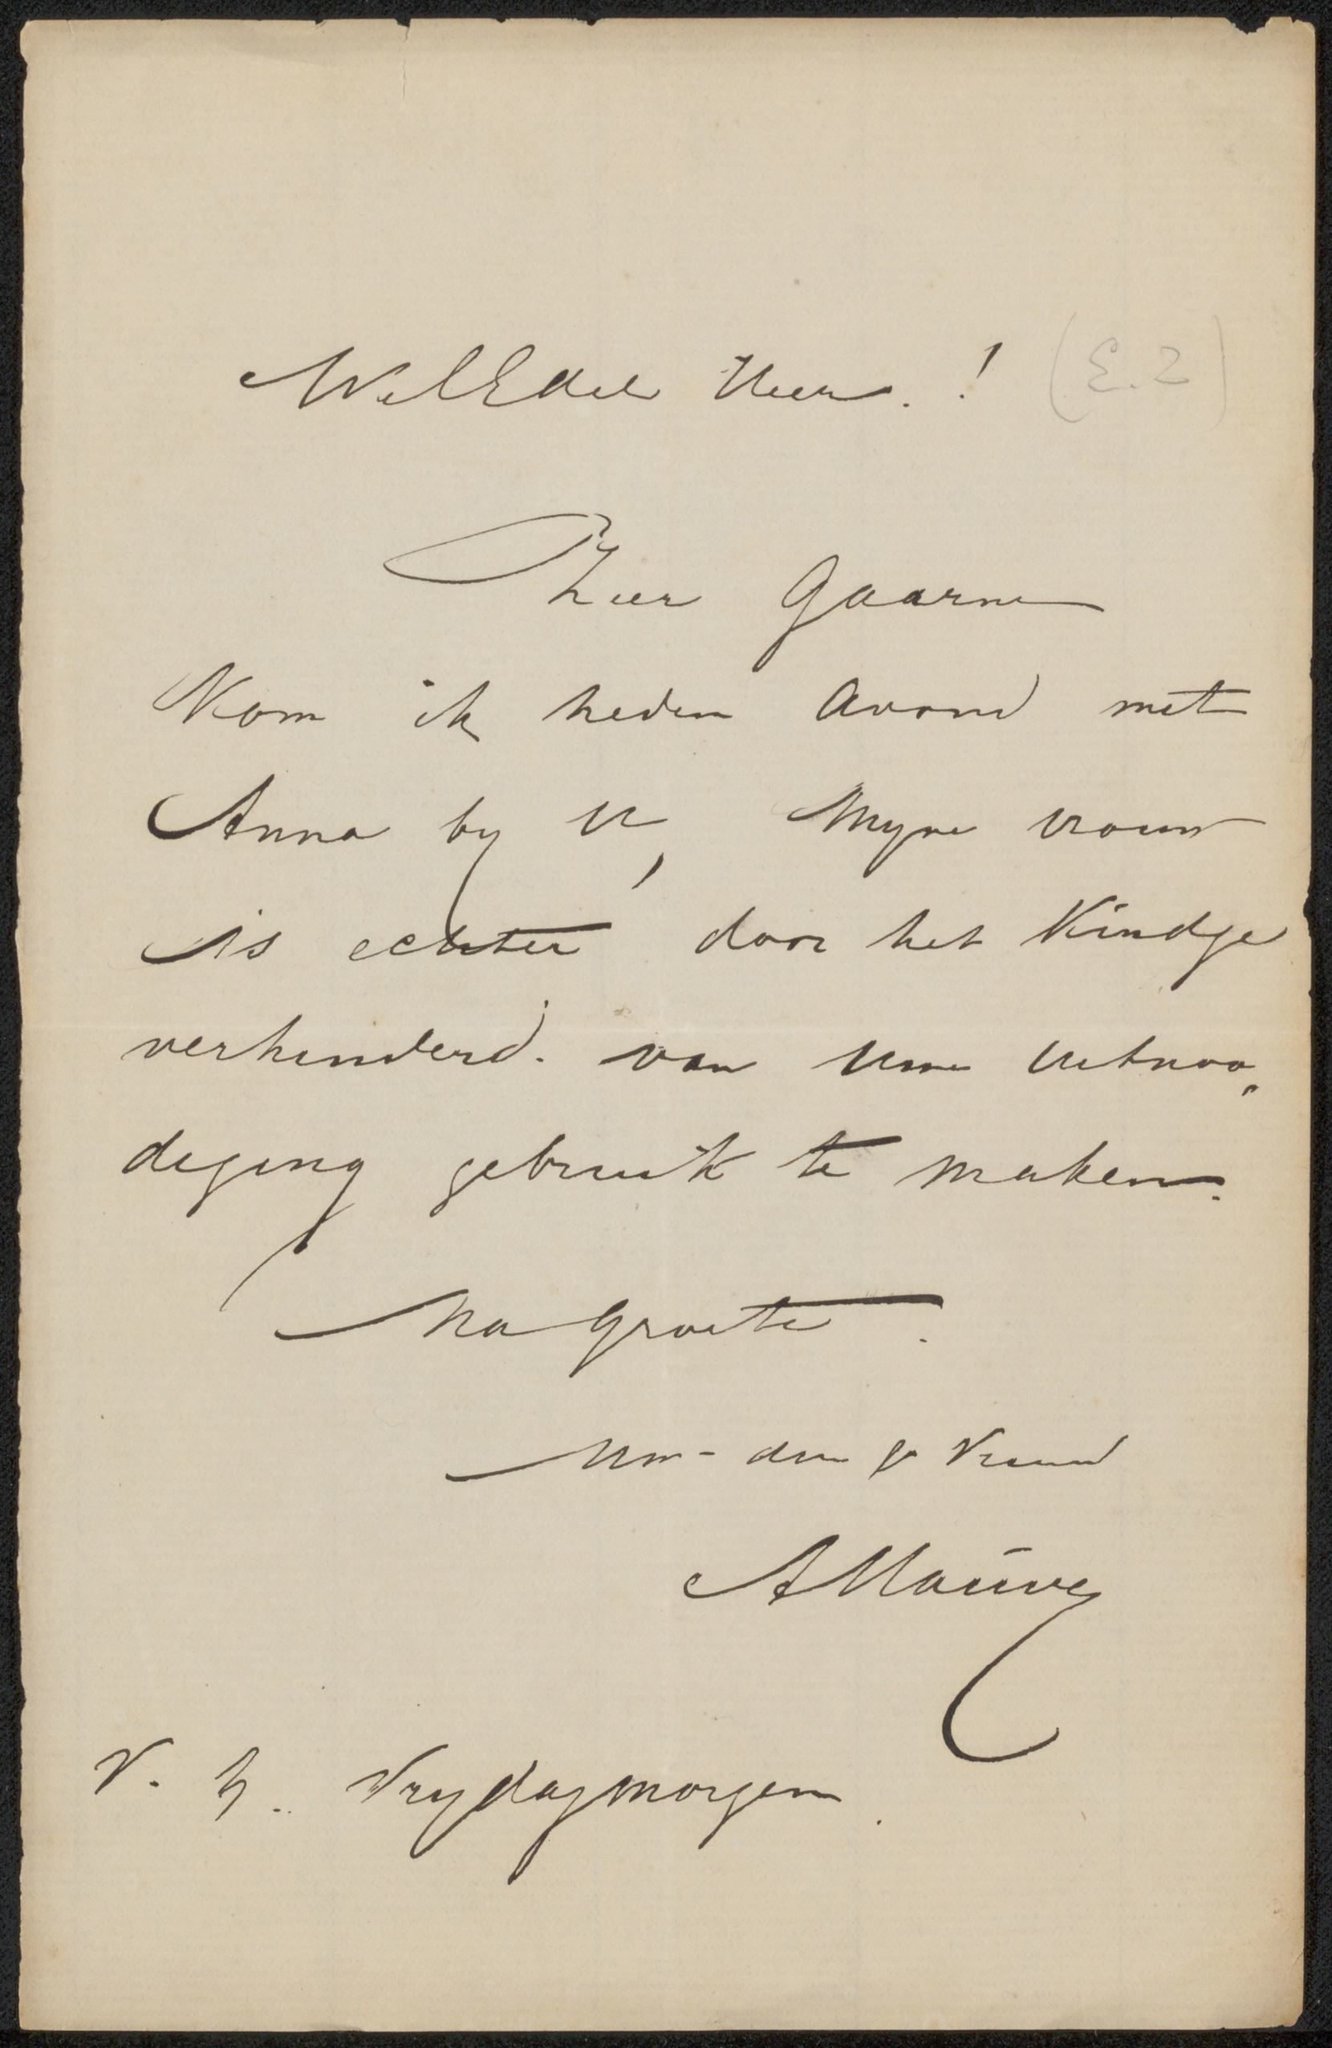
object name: letter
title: Brief aan Philip Zilcken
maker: anton mauve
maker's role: draughtsman, painter, print maker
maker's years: 1838-1888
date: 1867-1888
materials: ink, paper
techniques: pen, writing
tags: the hague, philip zilcken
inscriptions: collector's mark: ‘RPK’